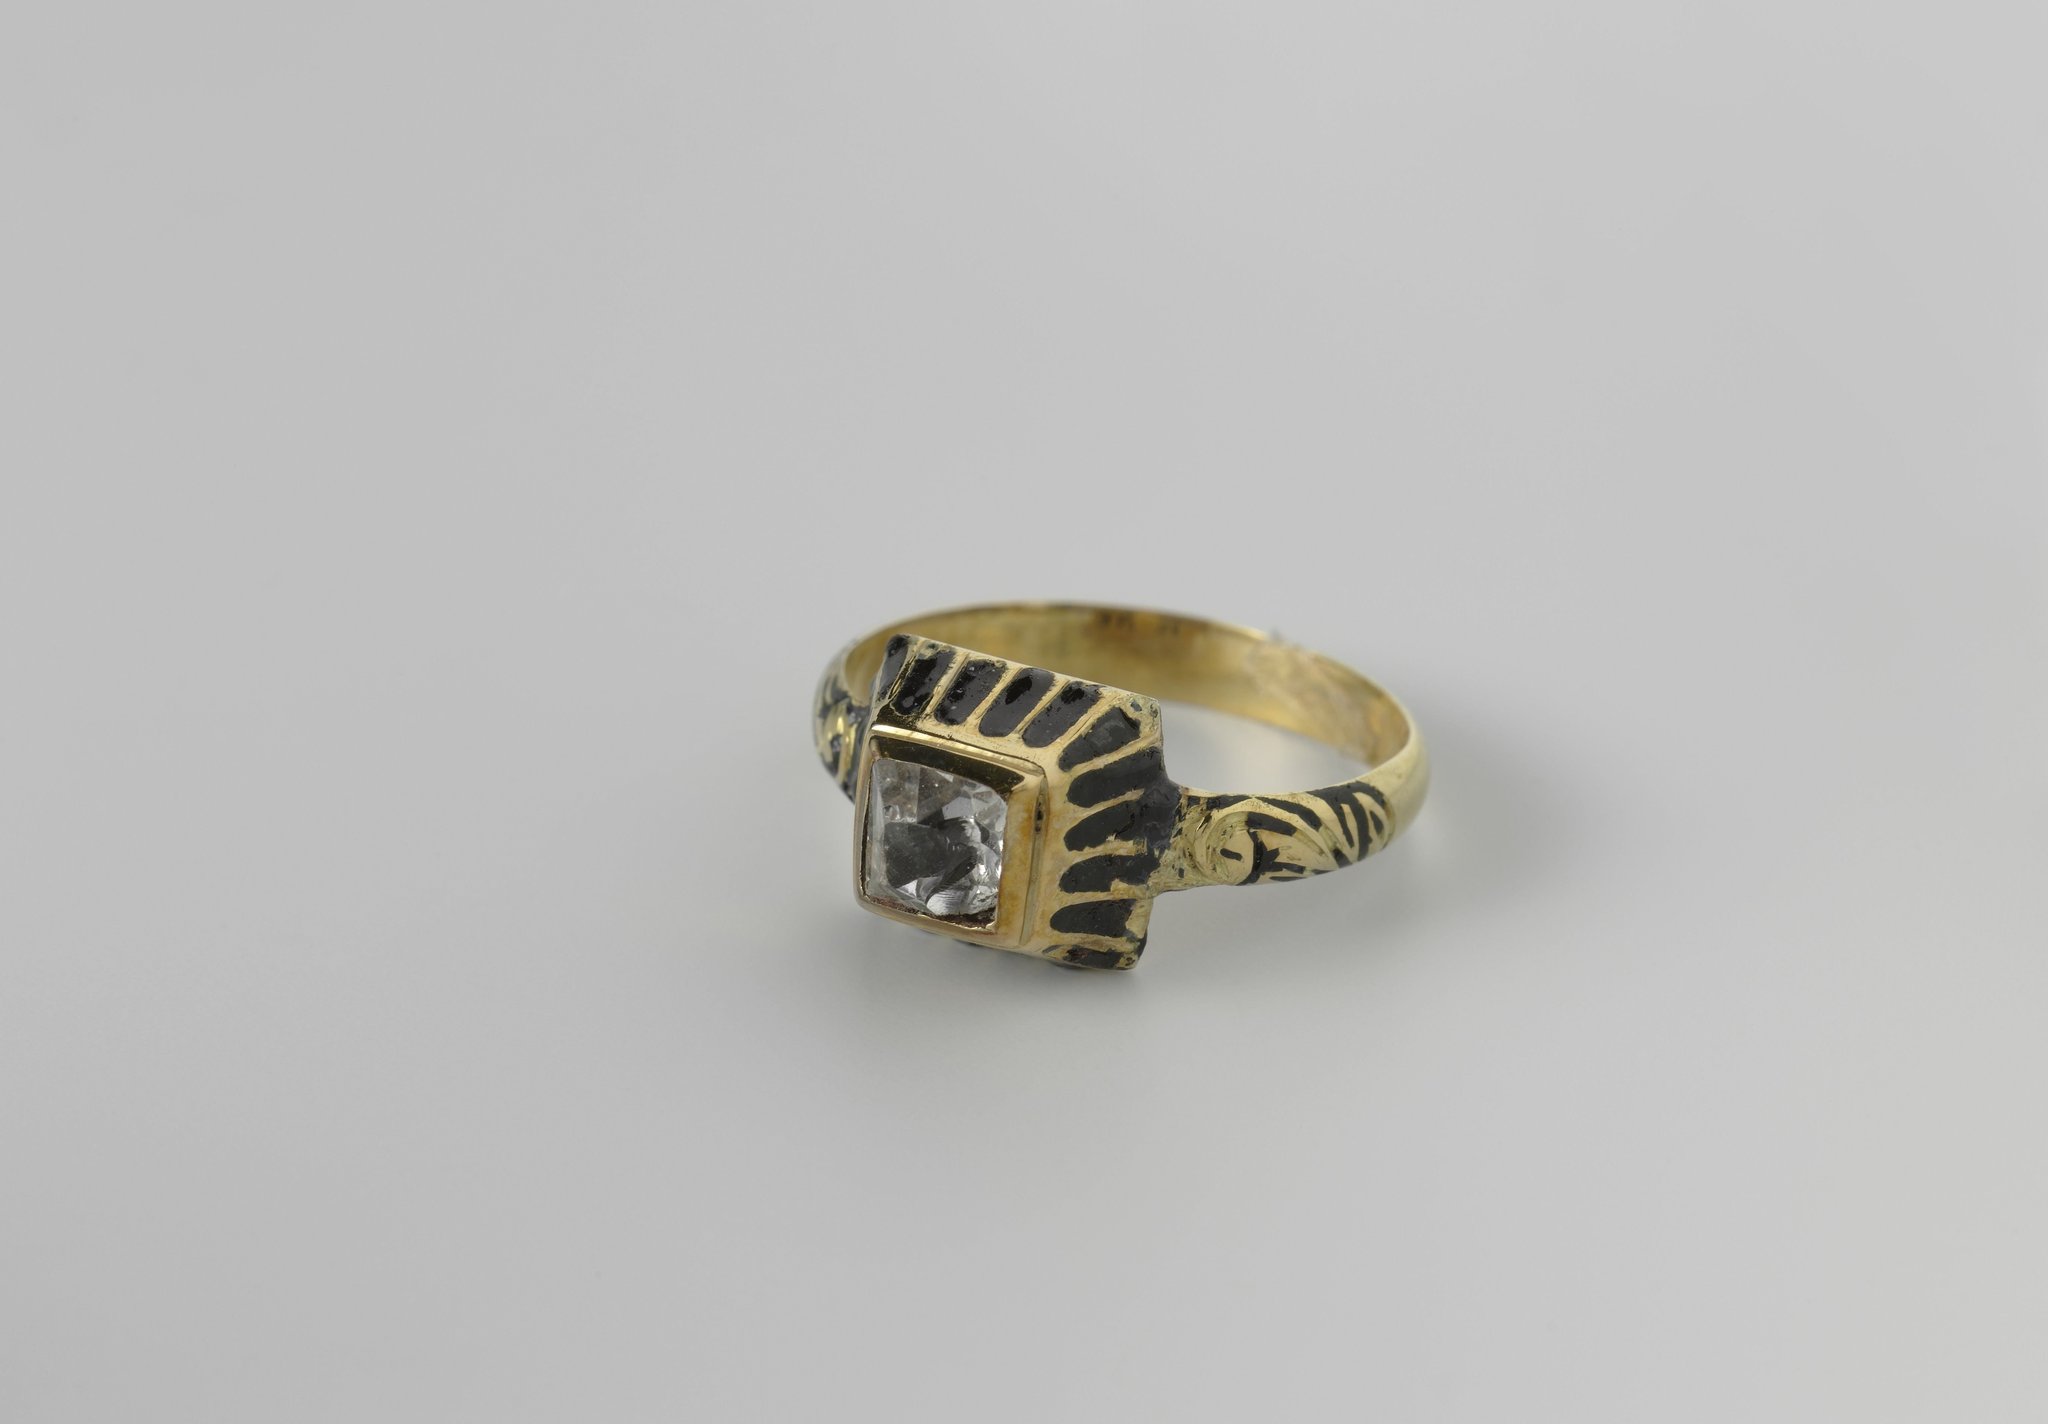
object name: ring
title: Ring with a table-cut diamond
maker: Anonymous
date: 1580-1620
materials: diamond, gold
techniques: enameling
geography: netherlands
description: Diamonds are octahedral crystals with a regular eightsided shape. In the early 16th century it was discovered how to cleave a crystal on its broadest side, which resulted in two joined pyramids. The shape most | commonly used in jewellery was the table-cut stone. This is an octahedron of which a little less than half of the top pyramid is sawn off.